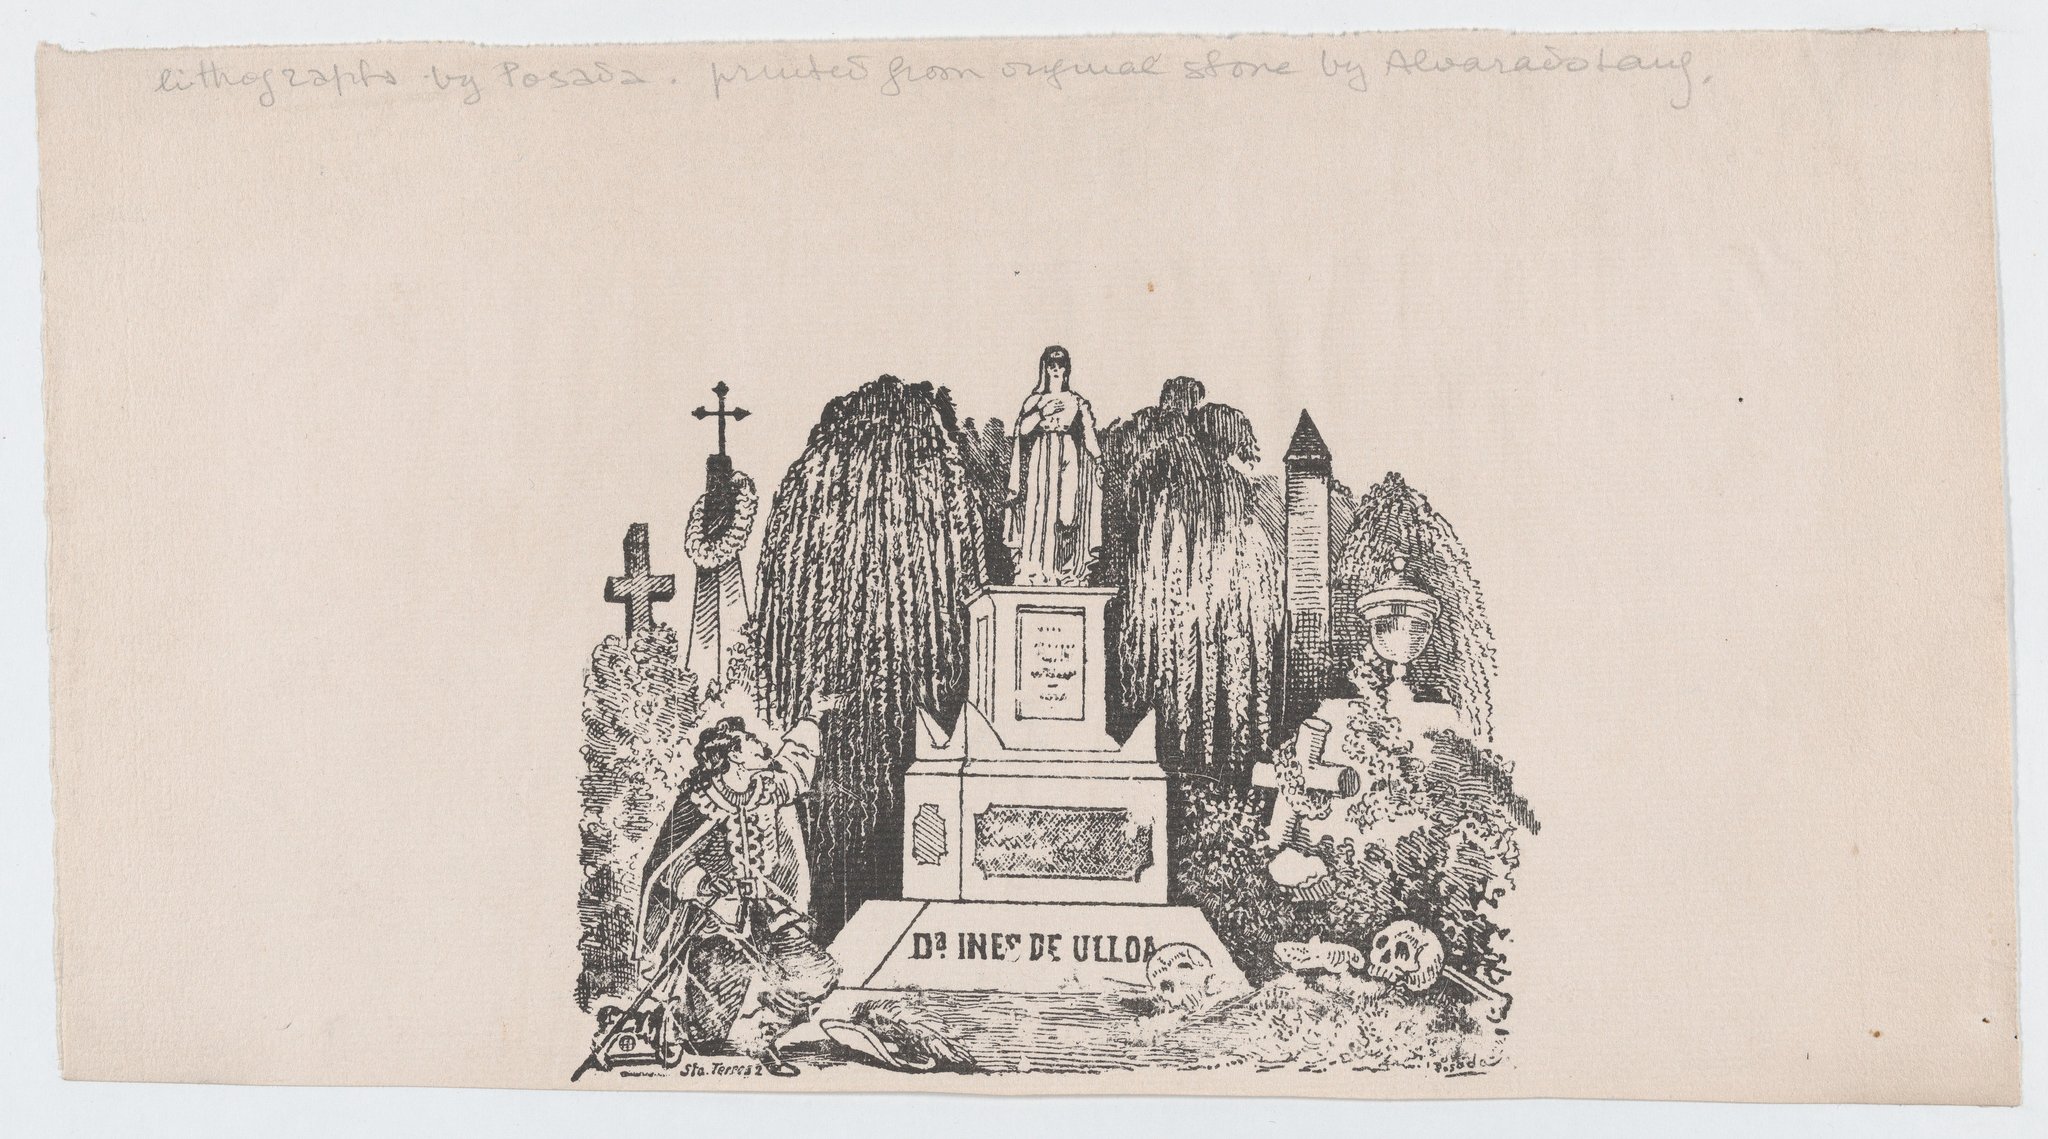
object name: print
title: Saint Theresa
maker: josé guadalupe posada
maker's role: artist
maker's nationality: mexican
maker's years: 1852-1913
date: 1890-1910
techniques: lithograph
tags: monuments,women,saints